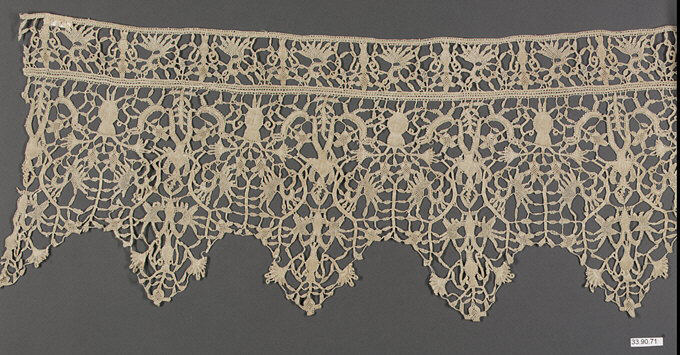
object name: border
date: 1601-1633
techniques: lace